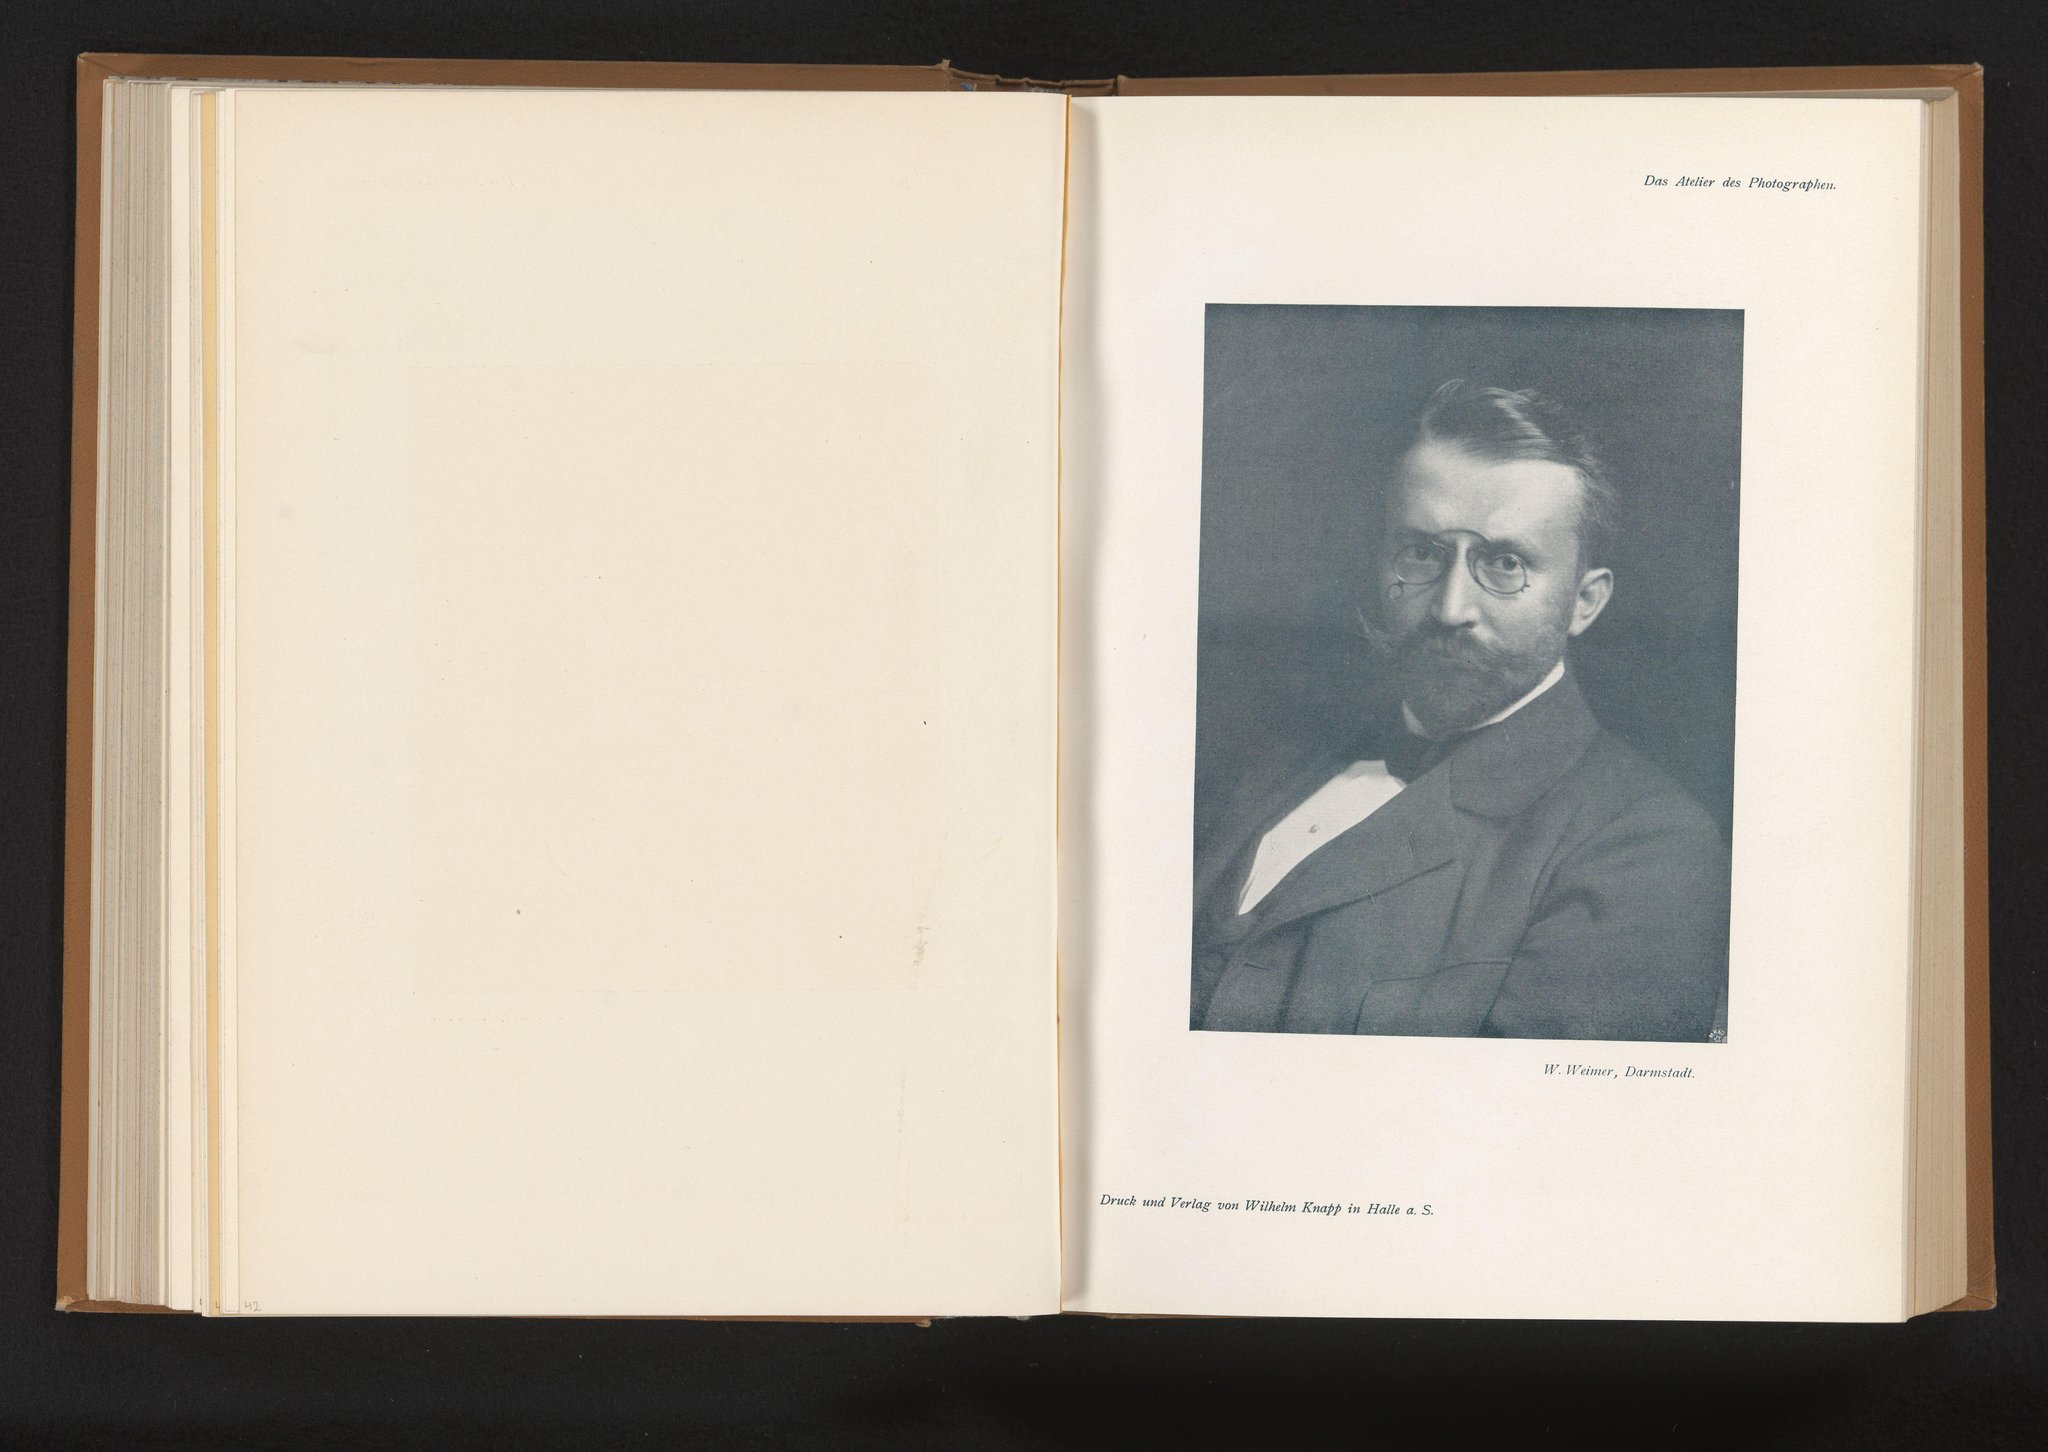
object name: photomechanical print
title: Portret van een onbekende man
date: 1895-1900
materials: paper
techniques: autotype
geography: berlin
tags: historical persons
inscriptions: inscription: ‘Das Atelier des Photographen.’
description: Prent op derde ongenummerde pagina na pagina 164.